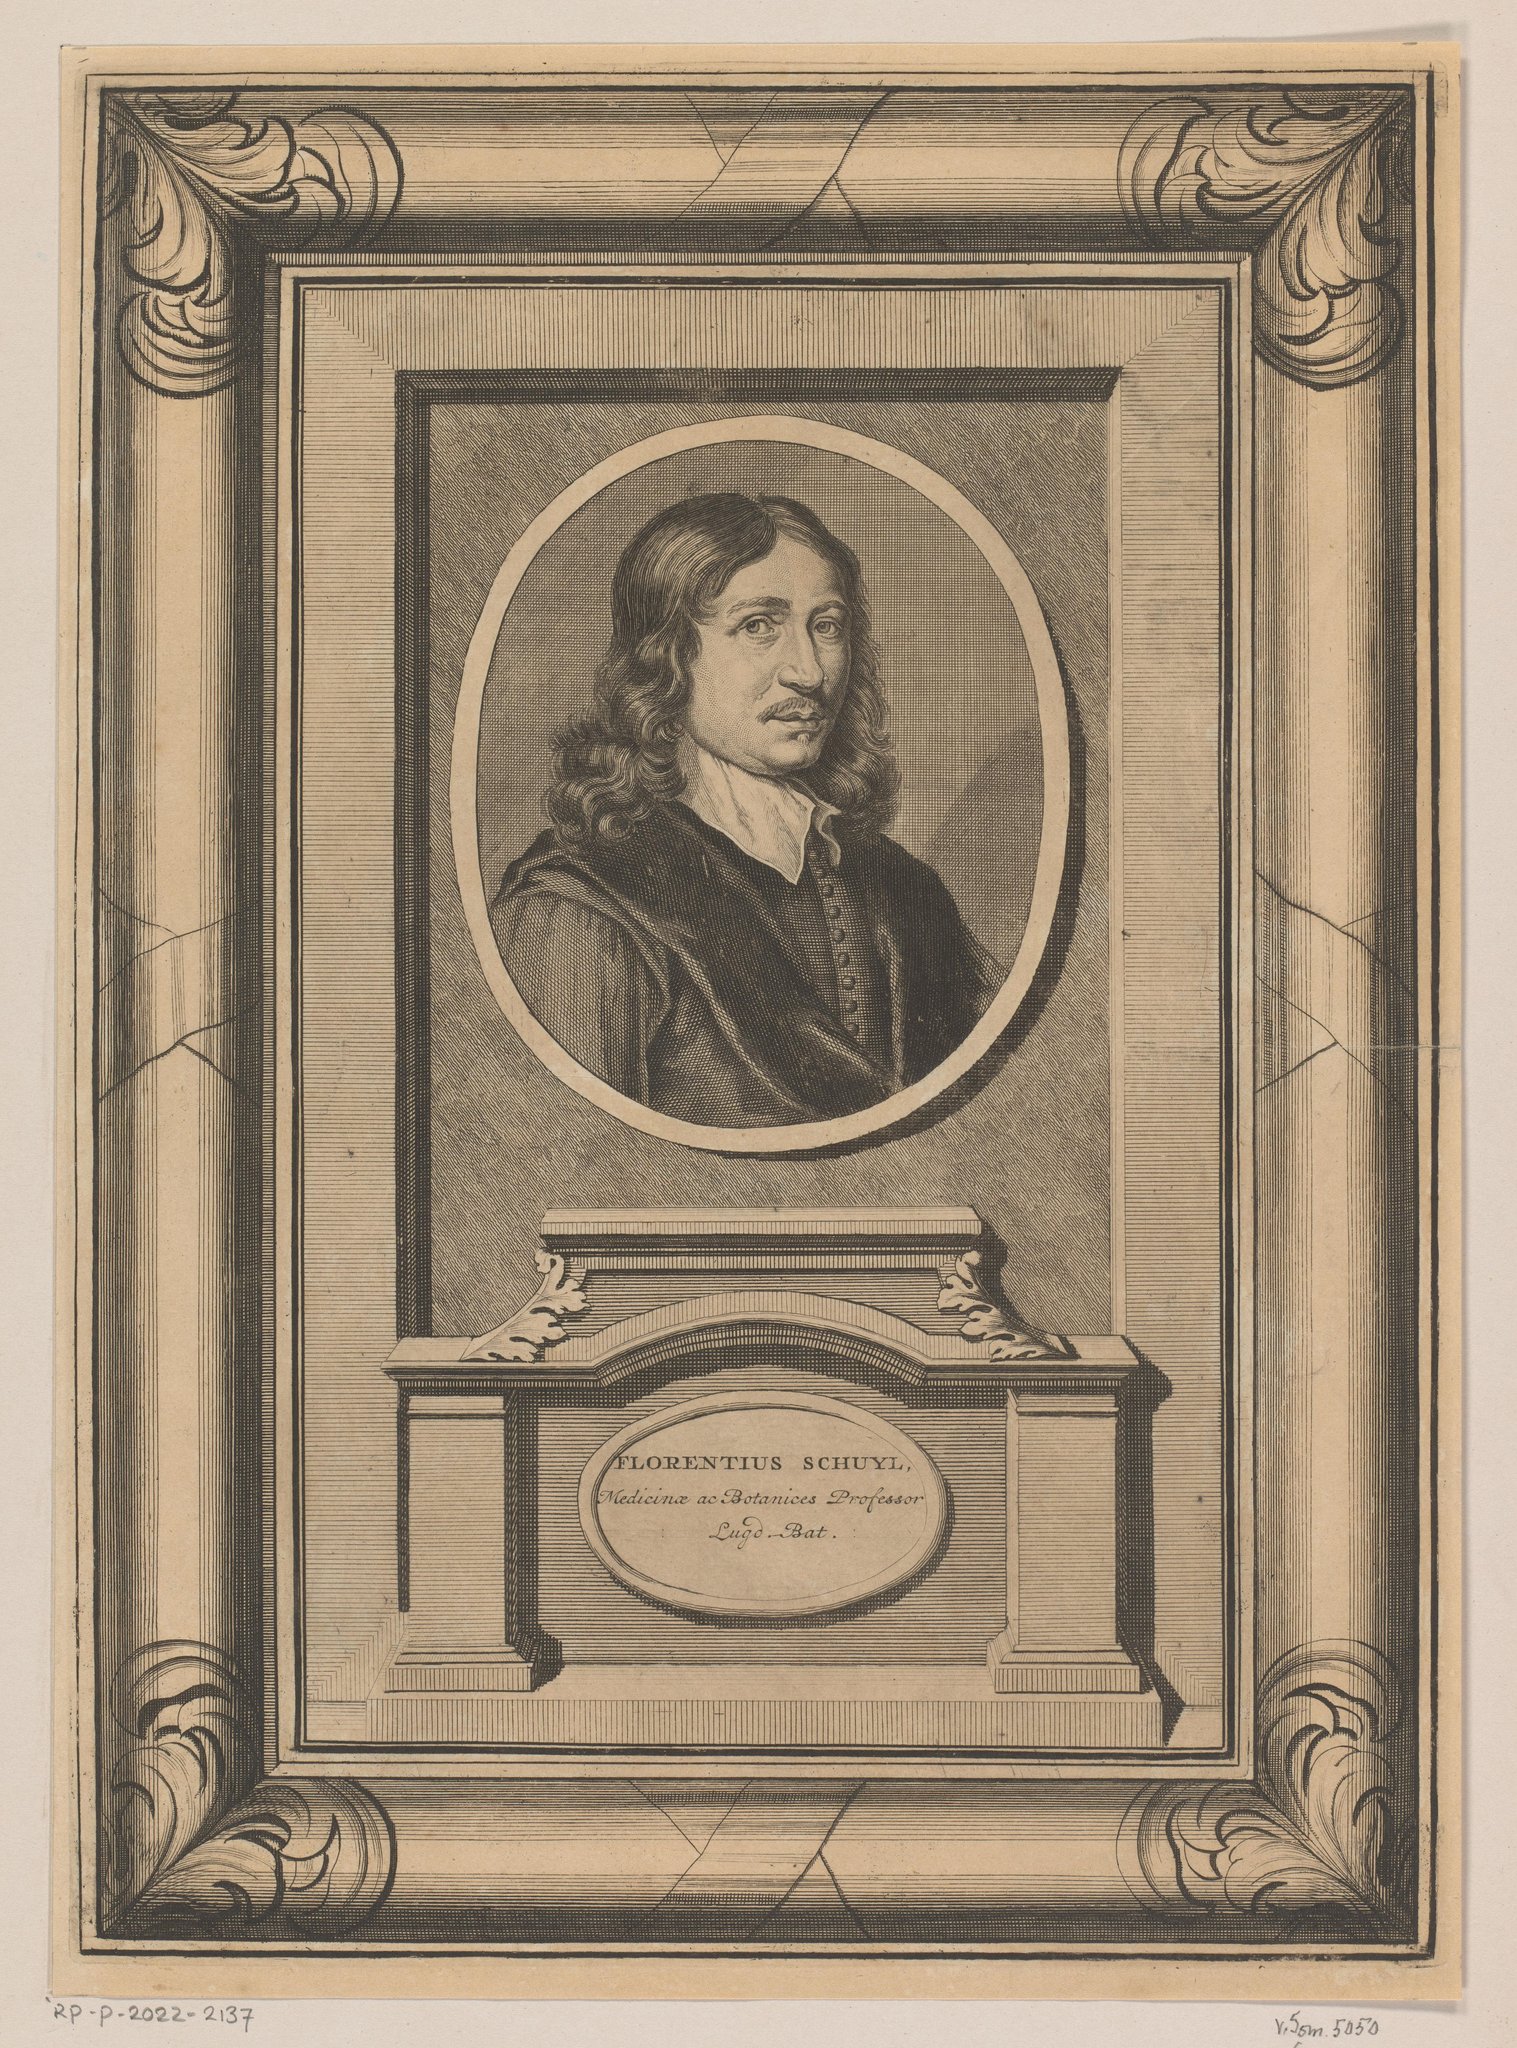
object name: print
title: Fundatoris, curatorum et professorum celeberrimorum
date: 1716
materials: paper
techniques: engraving, etching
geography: leiden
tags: botany (+ portrait of scholar, scientist), historical persons, physician, doctor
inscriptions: collector's mark: Lugt 2228